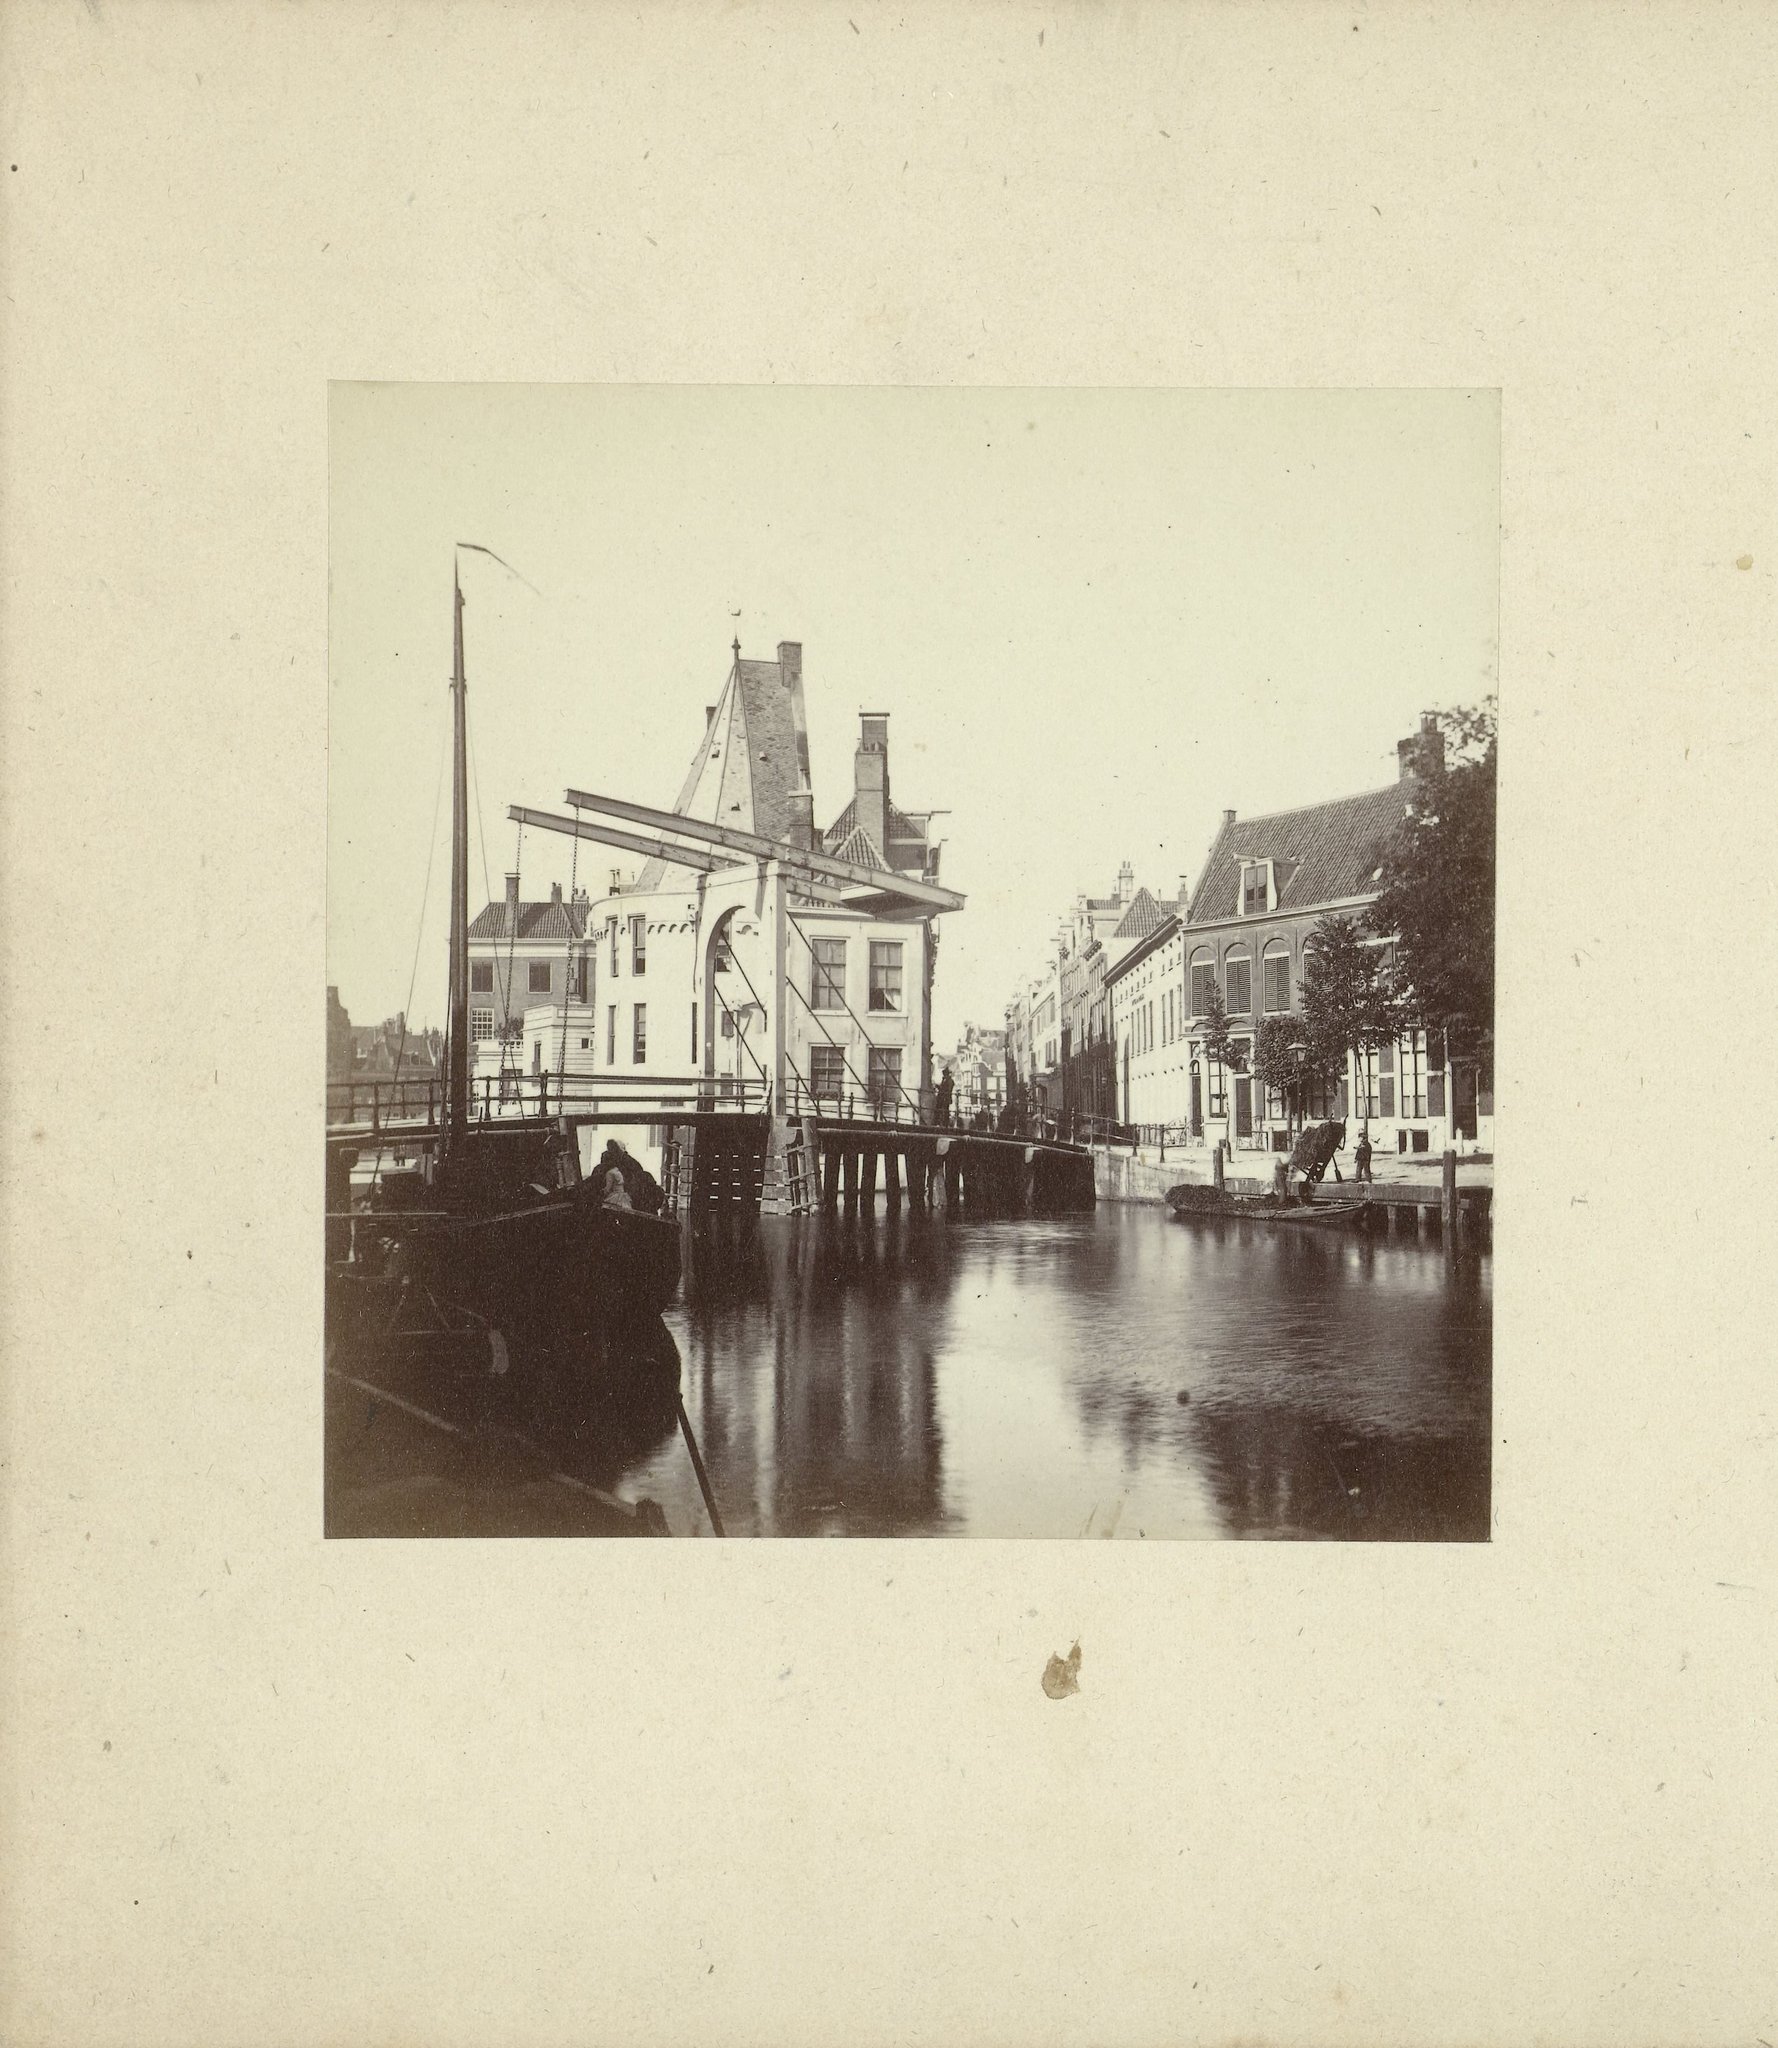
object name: photograph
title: Het Logement: de Doelen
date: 1860-1875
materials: cardboard, paper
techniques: albumen print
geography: amsterdam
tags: towers ~ fortified city